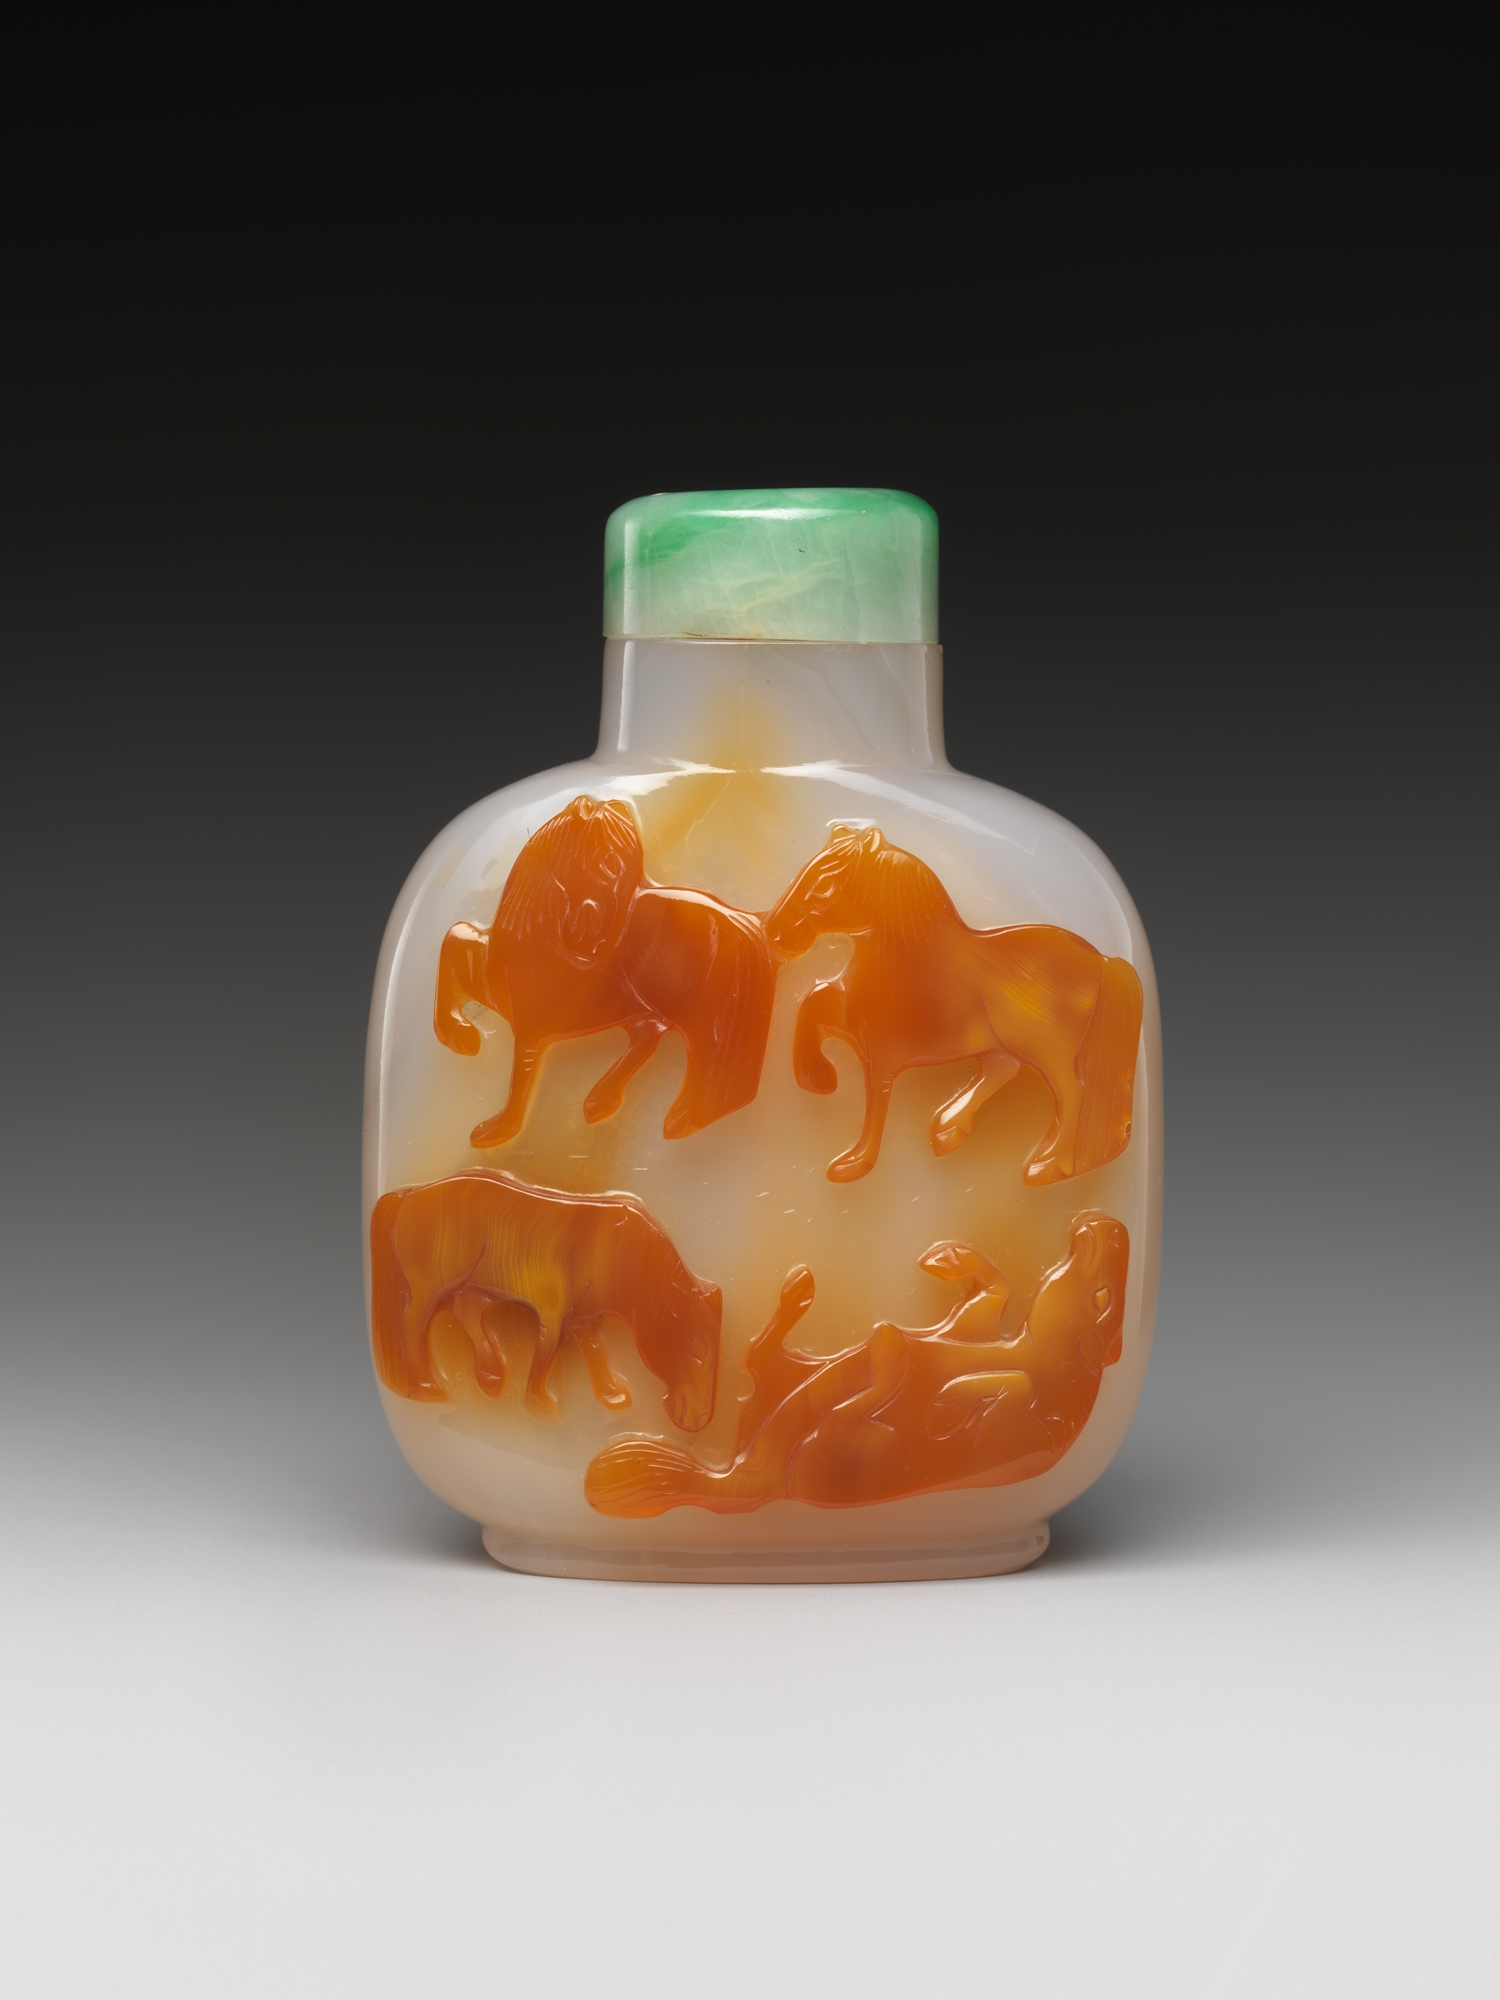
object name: snuff bottle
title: Snuff Bottle with Eight Horses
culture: chinese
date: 1767-1833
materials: stone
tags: horses